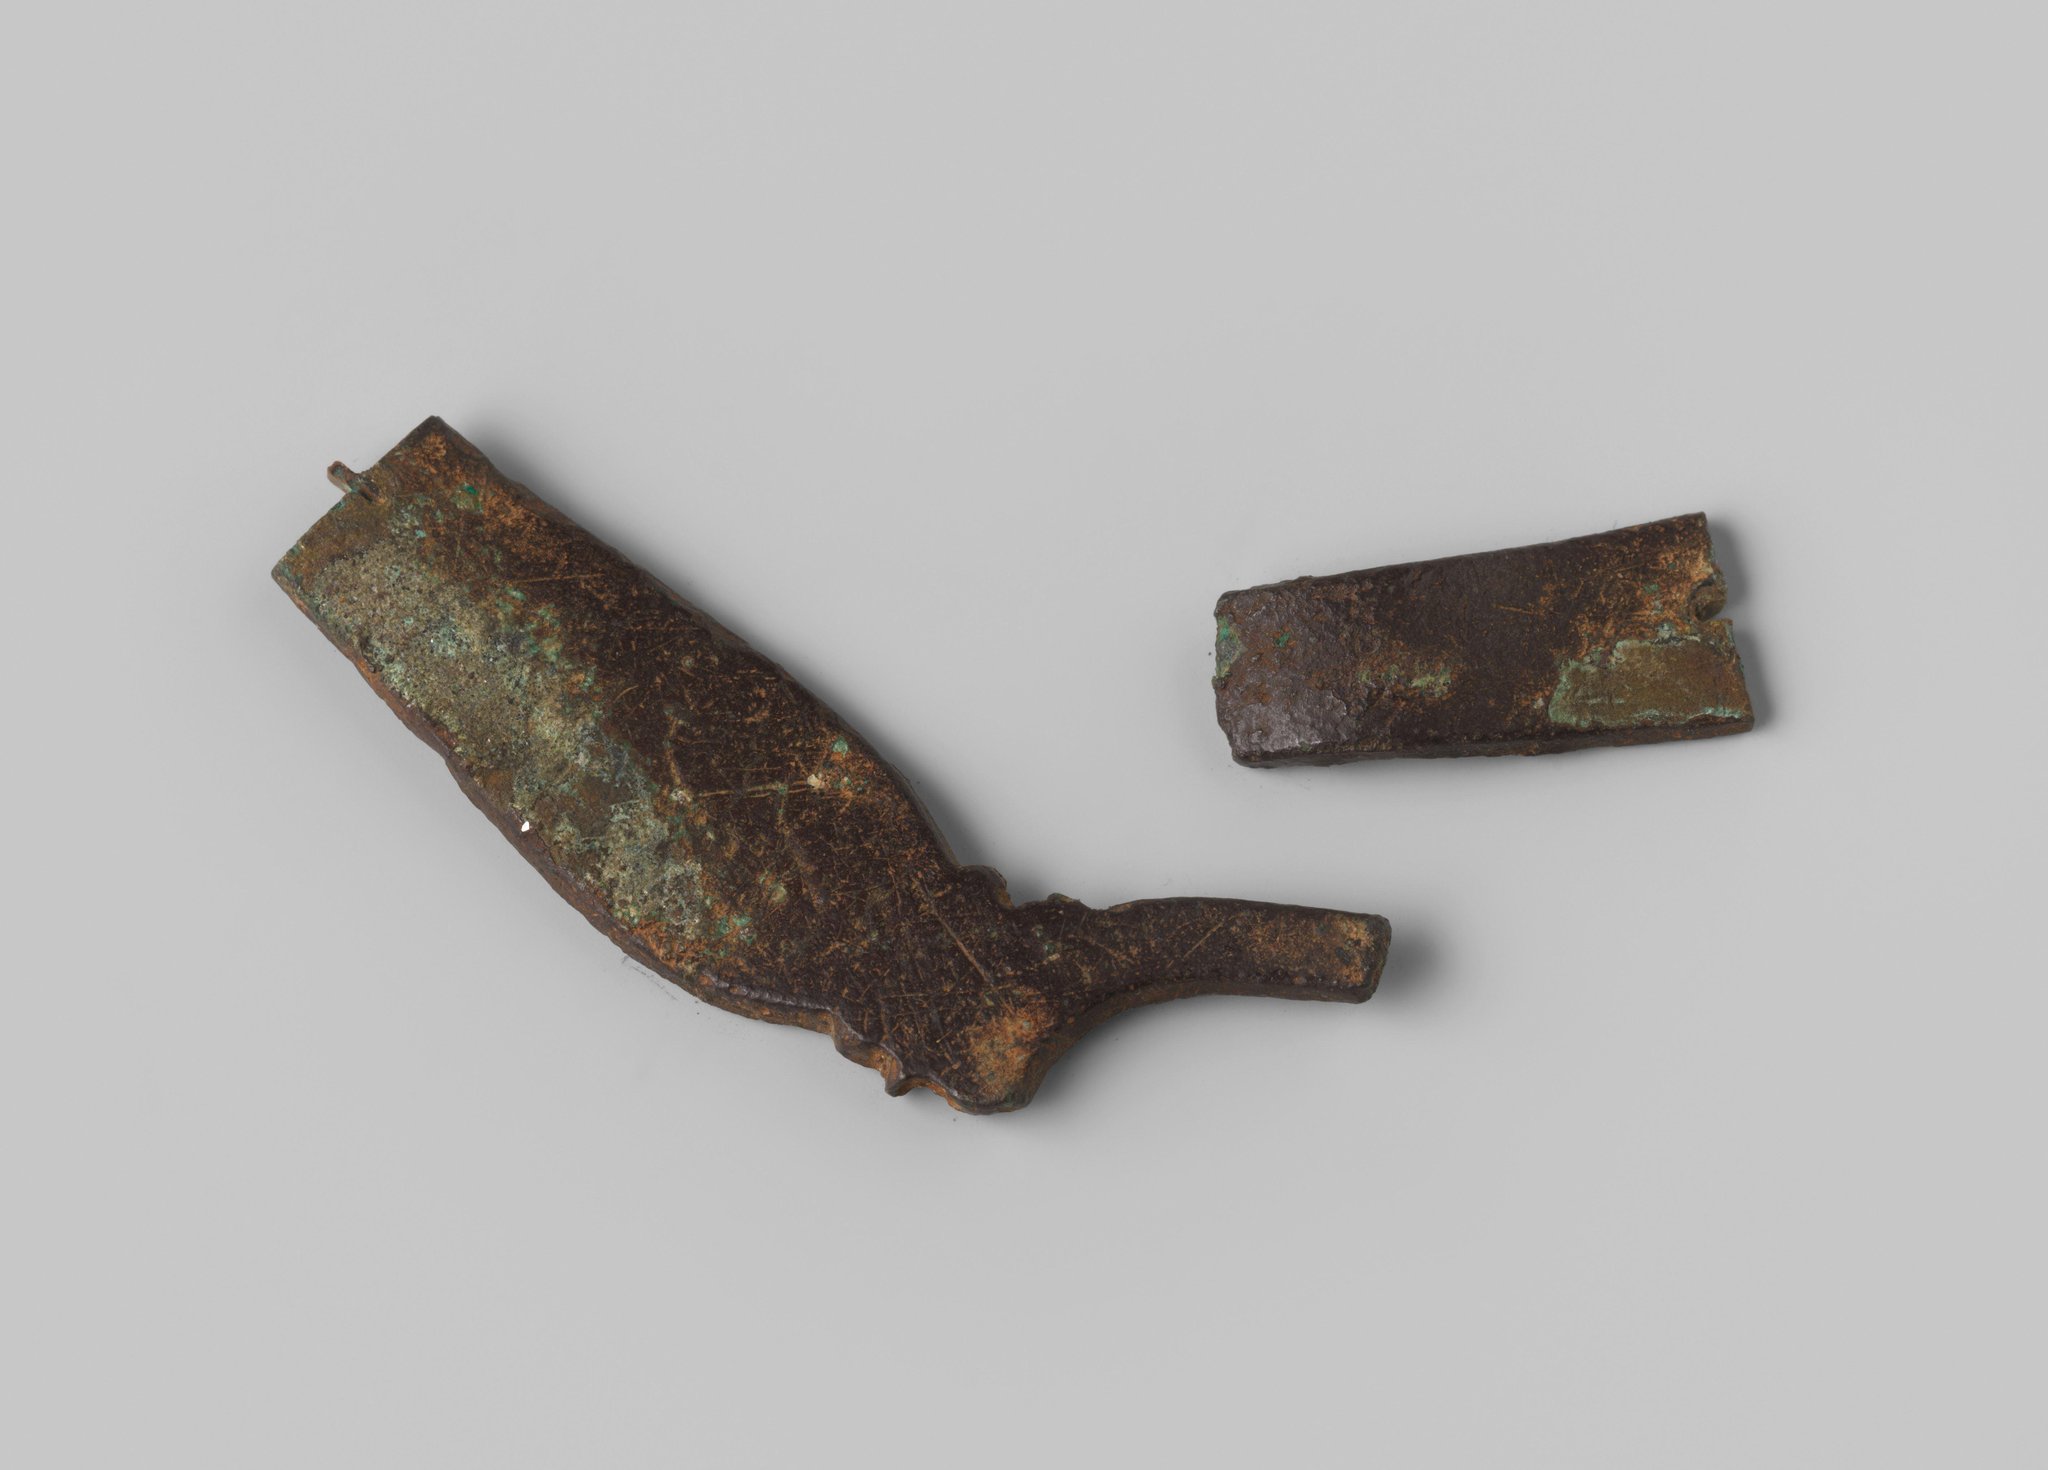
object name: handle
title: Fragmenten handvat van een lamp uit het wrak van de Oost-Indiëvaarder Hollandia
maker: Anonymous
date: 1700-1743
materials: copper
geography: netherlands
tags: verenigde oostindische compagnie, hollandia (schip), annet